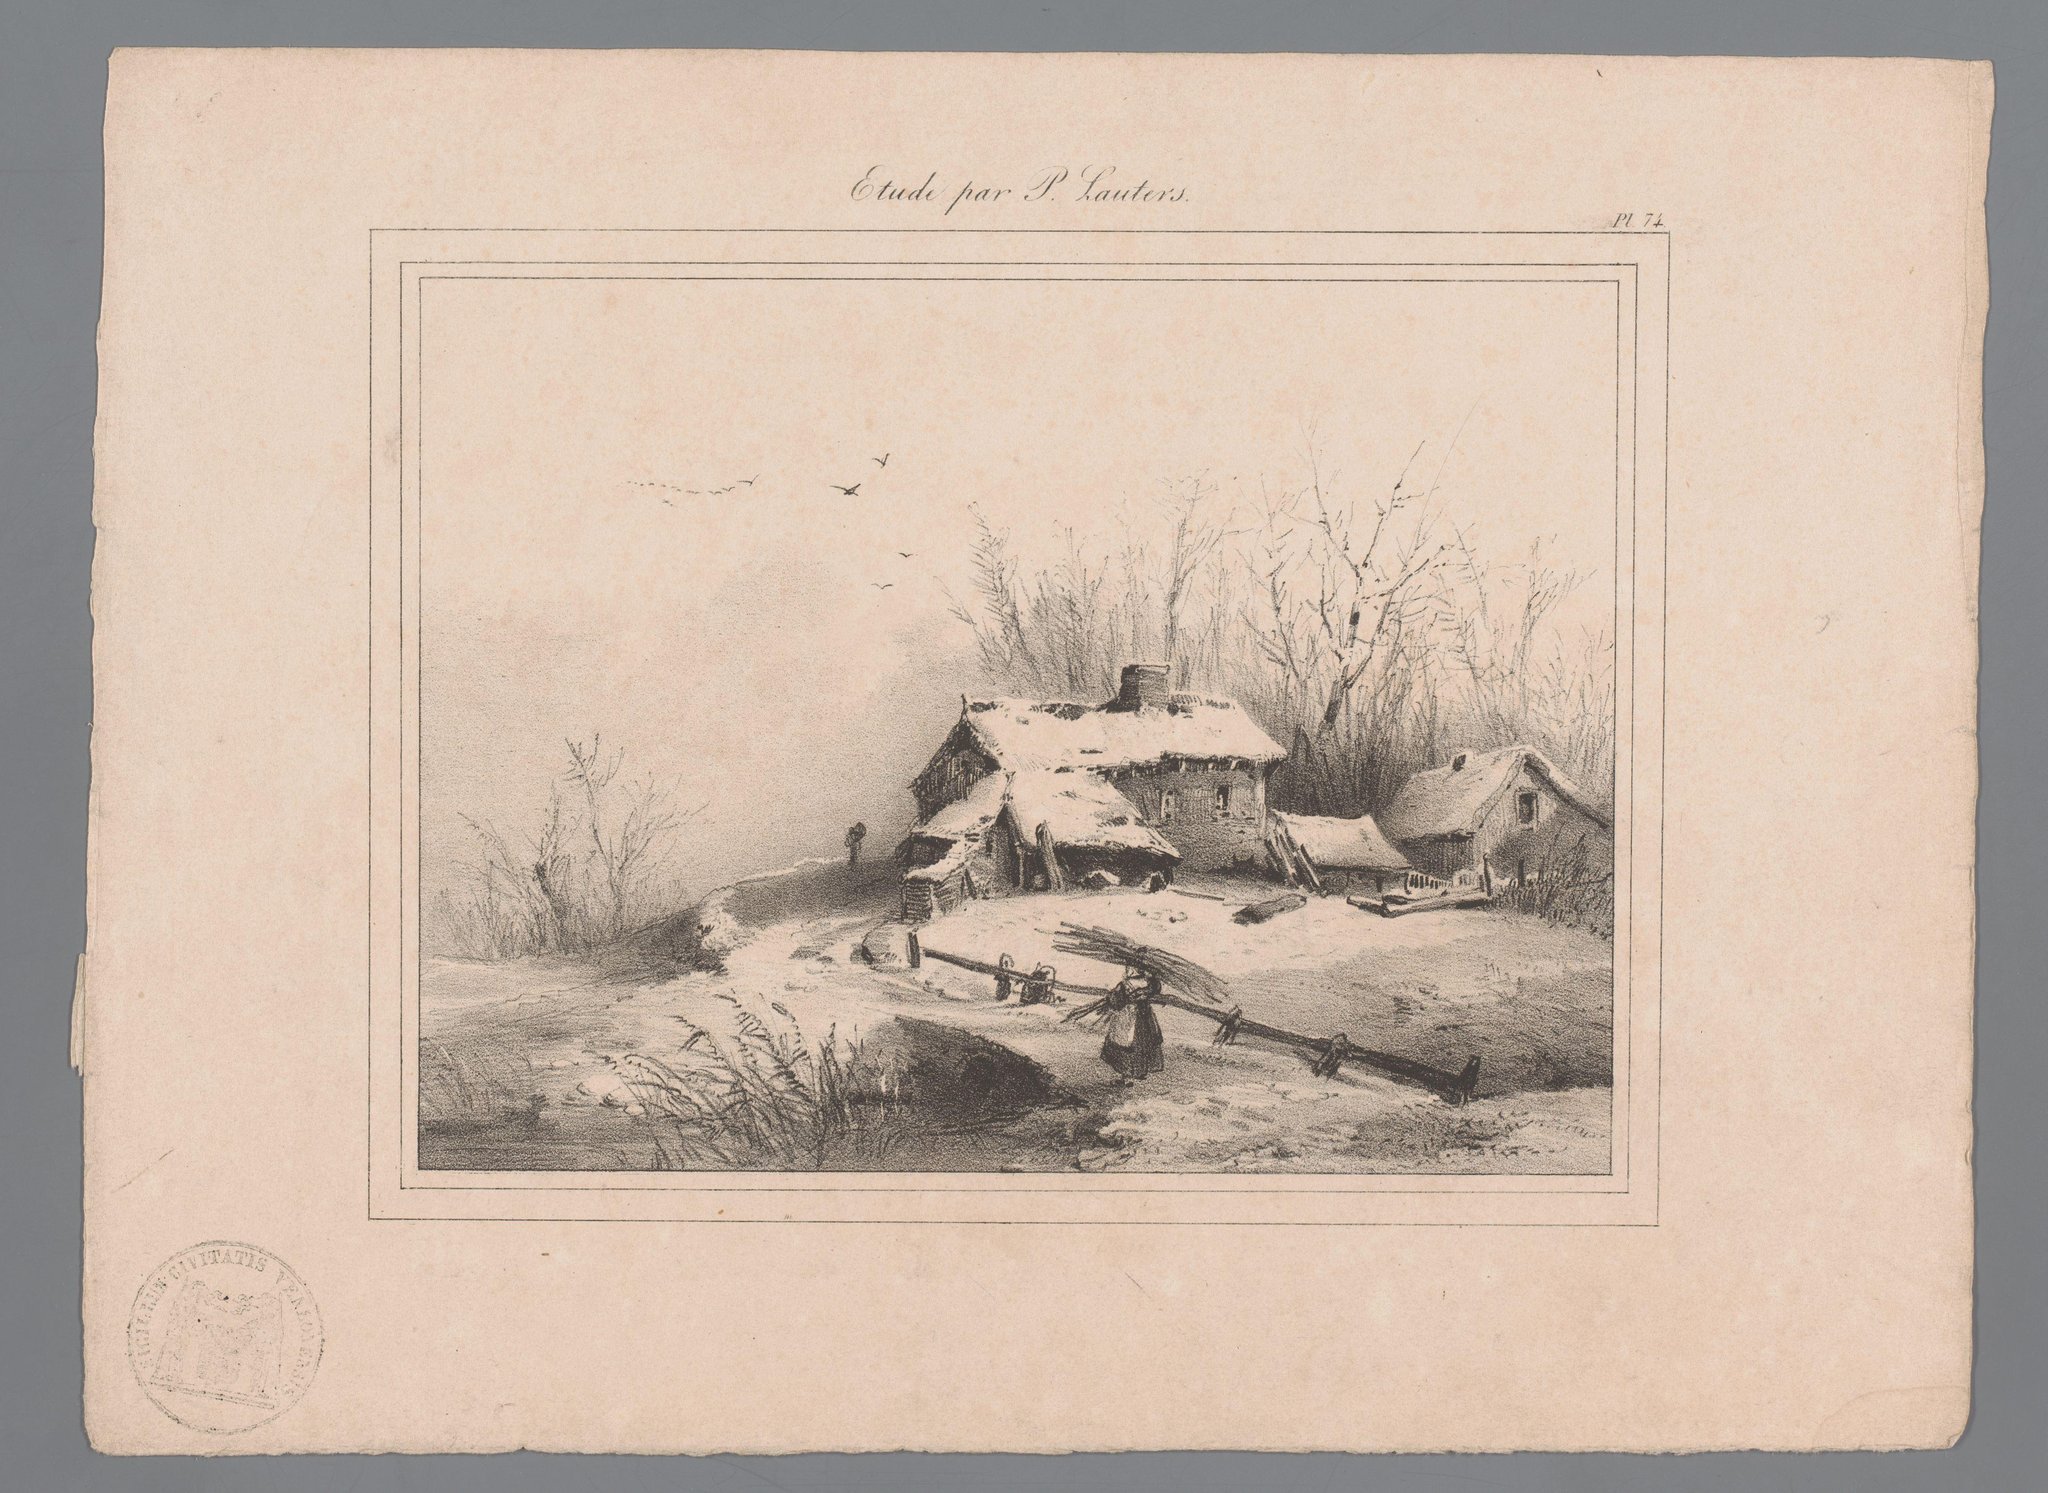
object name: print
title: Études de paysage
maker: paulus lauters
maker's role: print maker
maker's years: 1806-1875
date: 1832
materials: paper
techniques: lithograph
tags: snow, farm or solitary house in landscape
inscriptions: collector's mark: Lugt 2228, collector's mark: ‘Sigillum Civitatis Venlonessis’